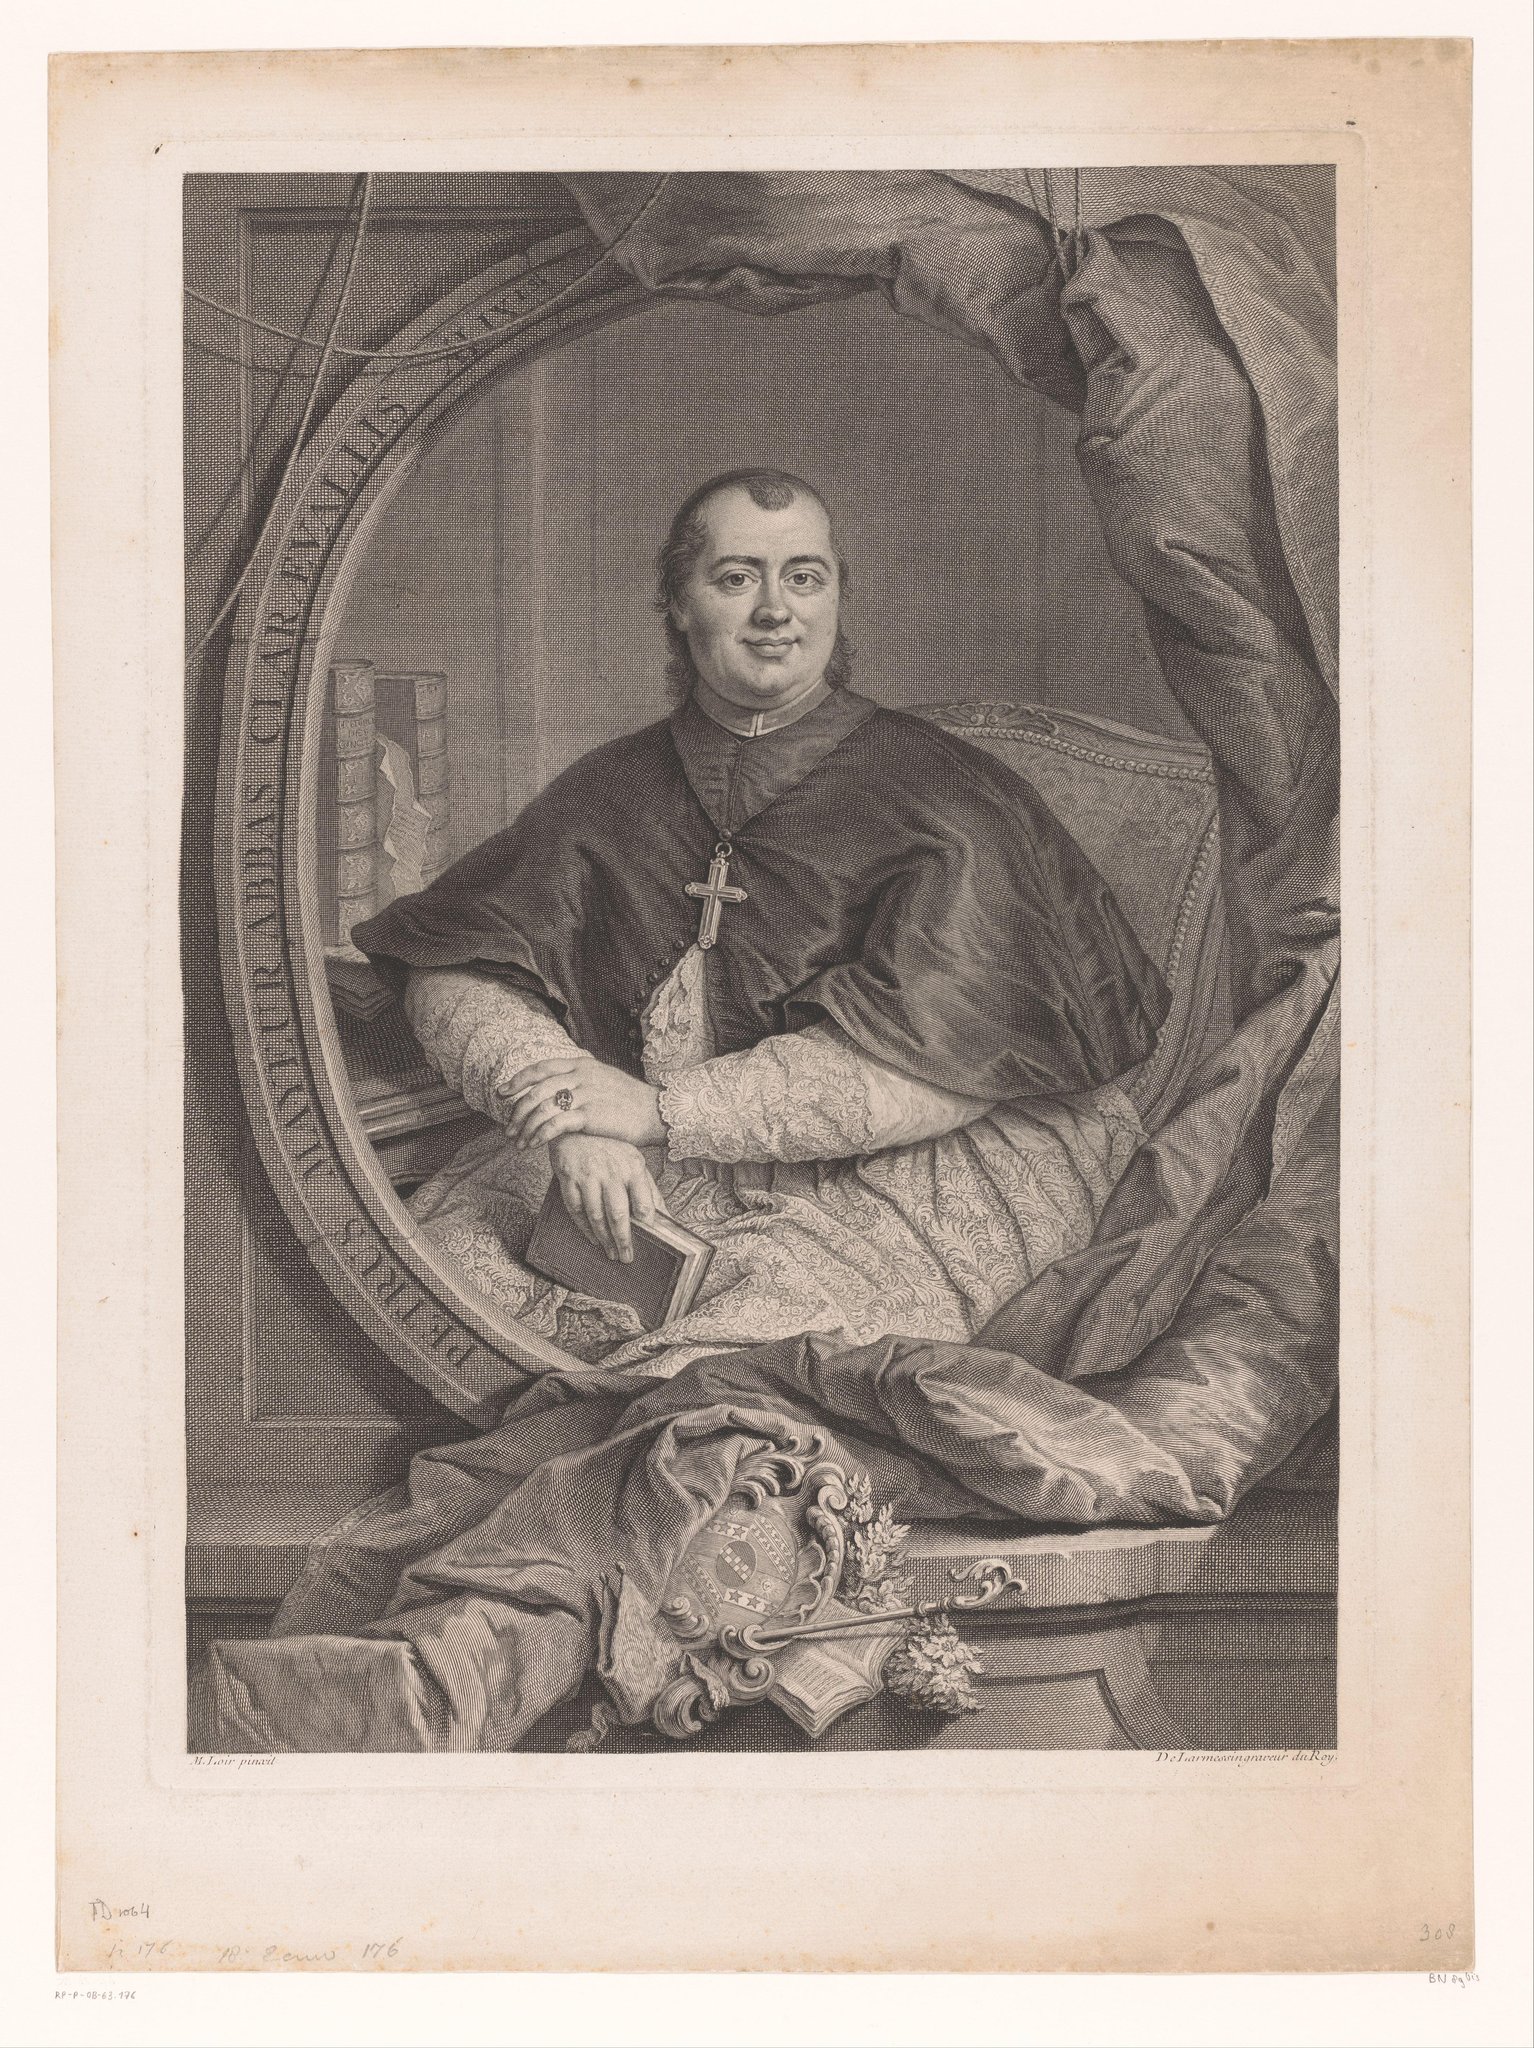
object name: print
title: Portret van Pierre Mayeur, abt van Clairvaux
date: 1740-1745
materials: paper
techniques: engraving, etching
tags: abbot, historical persons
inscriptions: collector's mark: Lugt 240